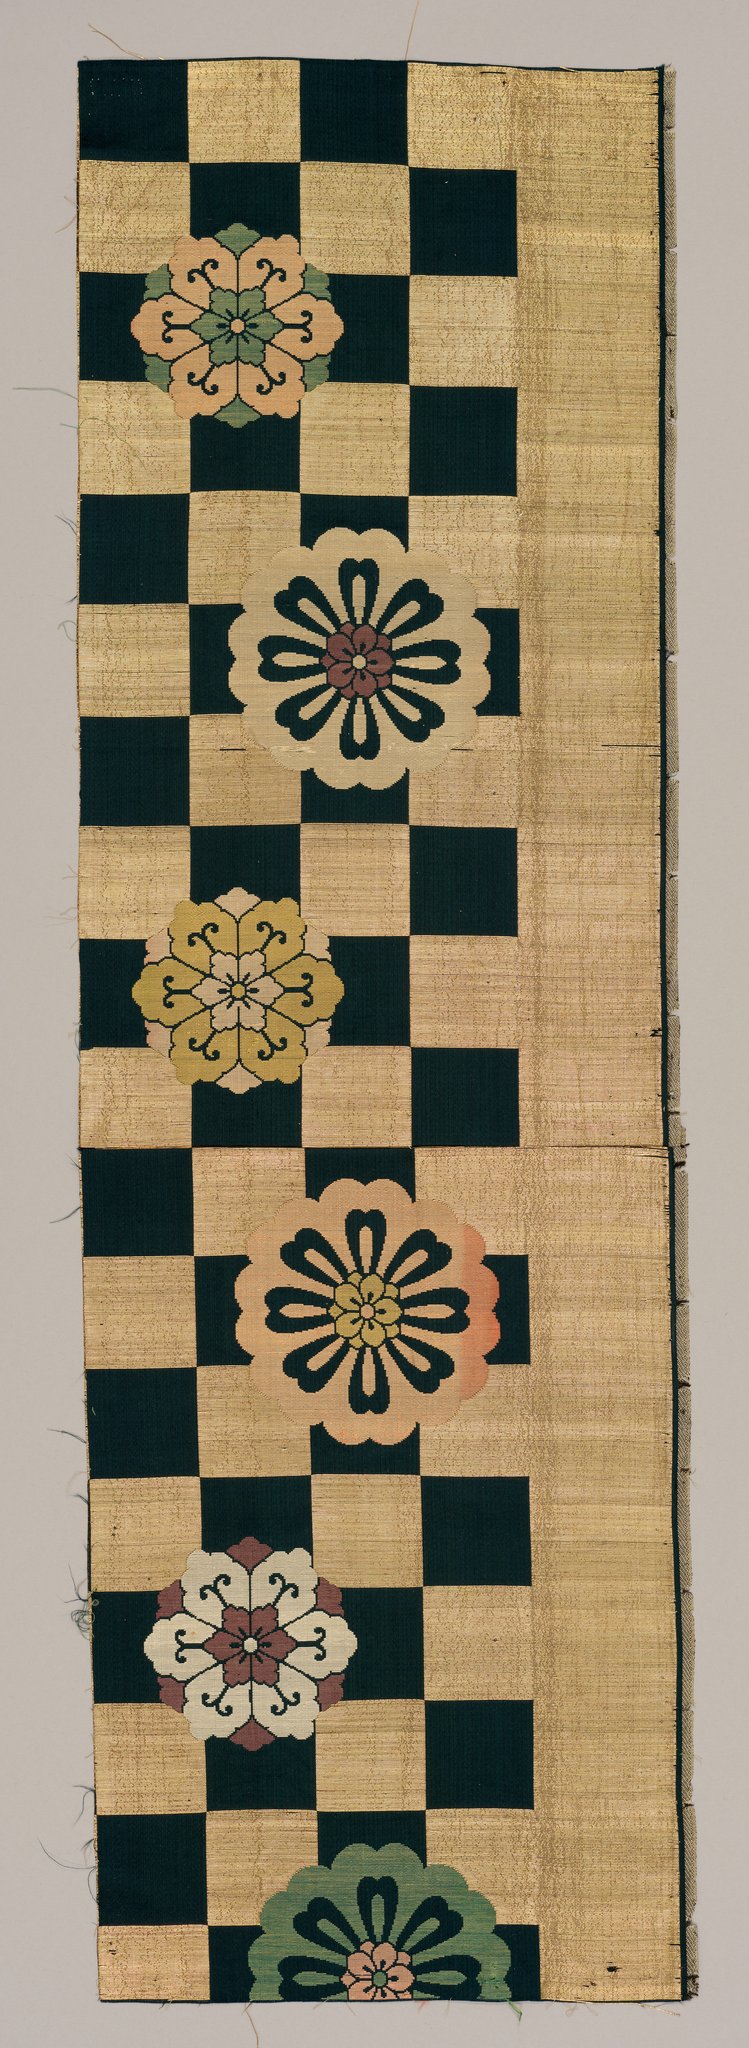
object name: piece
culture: japanese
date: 1801-1900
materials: gold, paper, silk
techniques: brocade